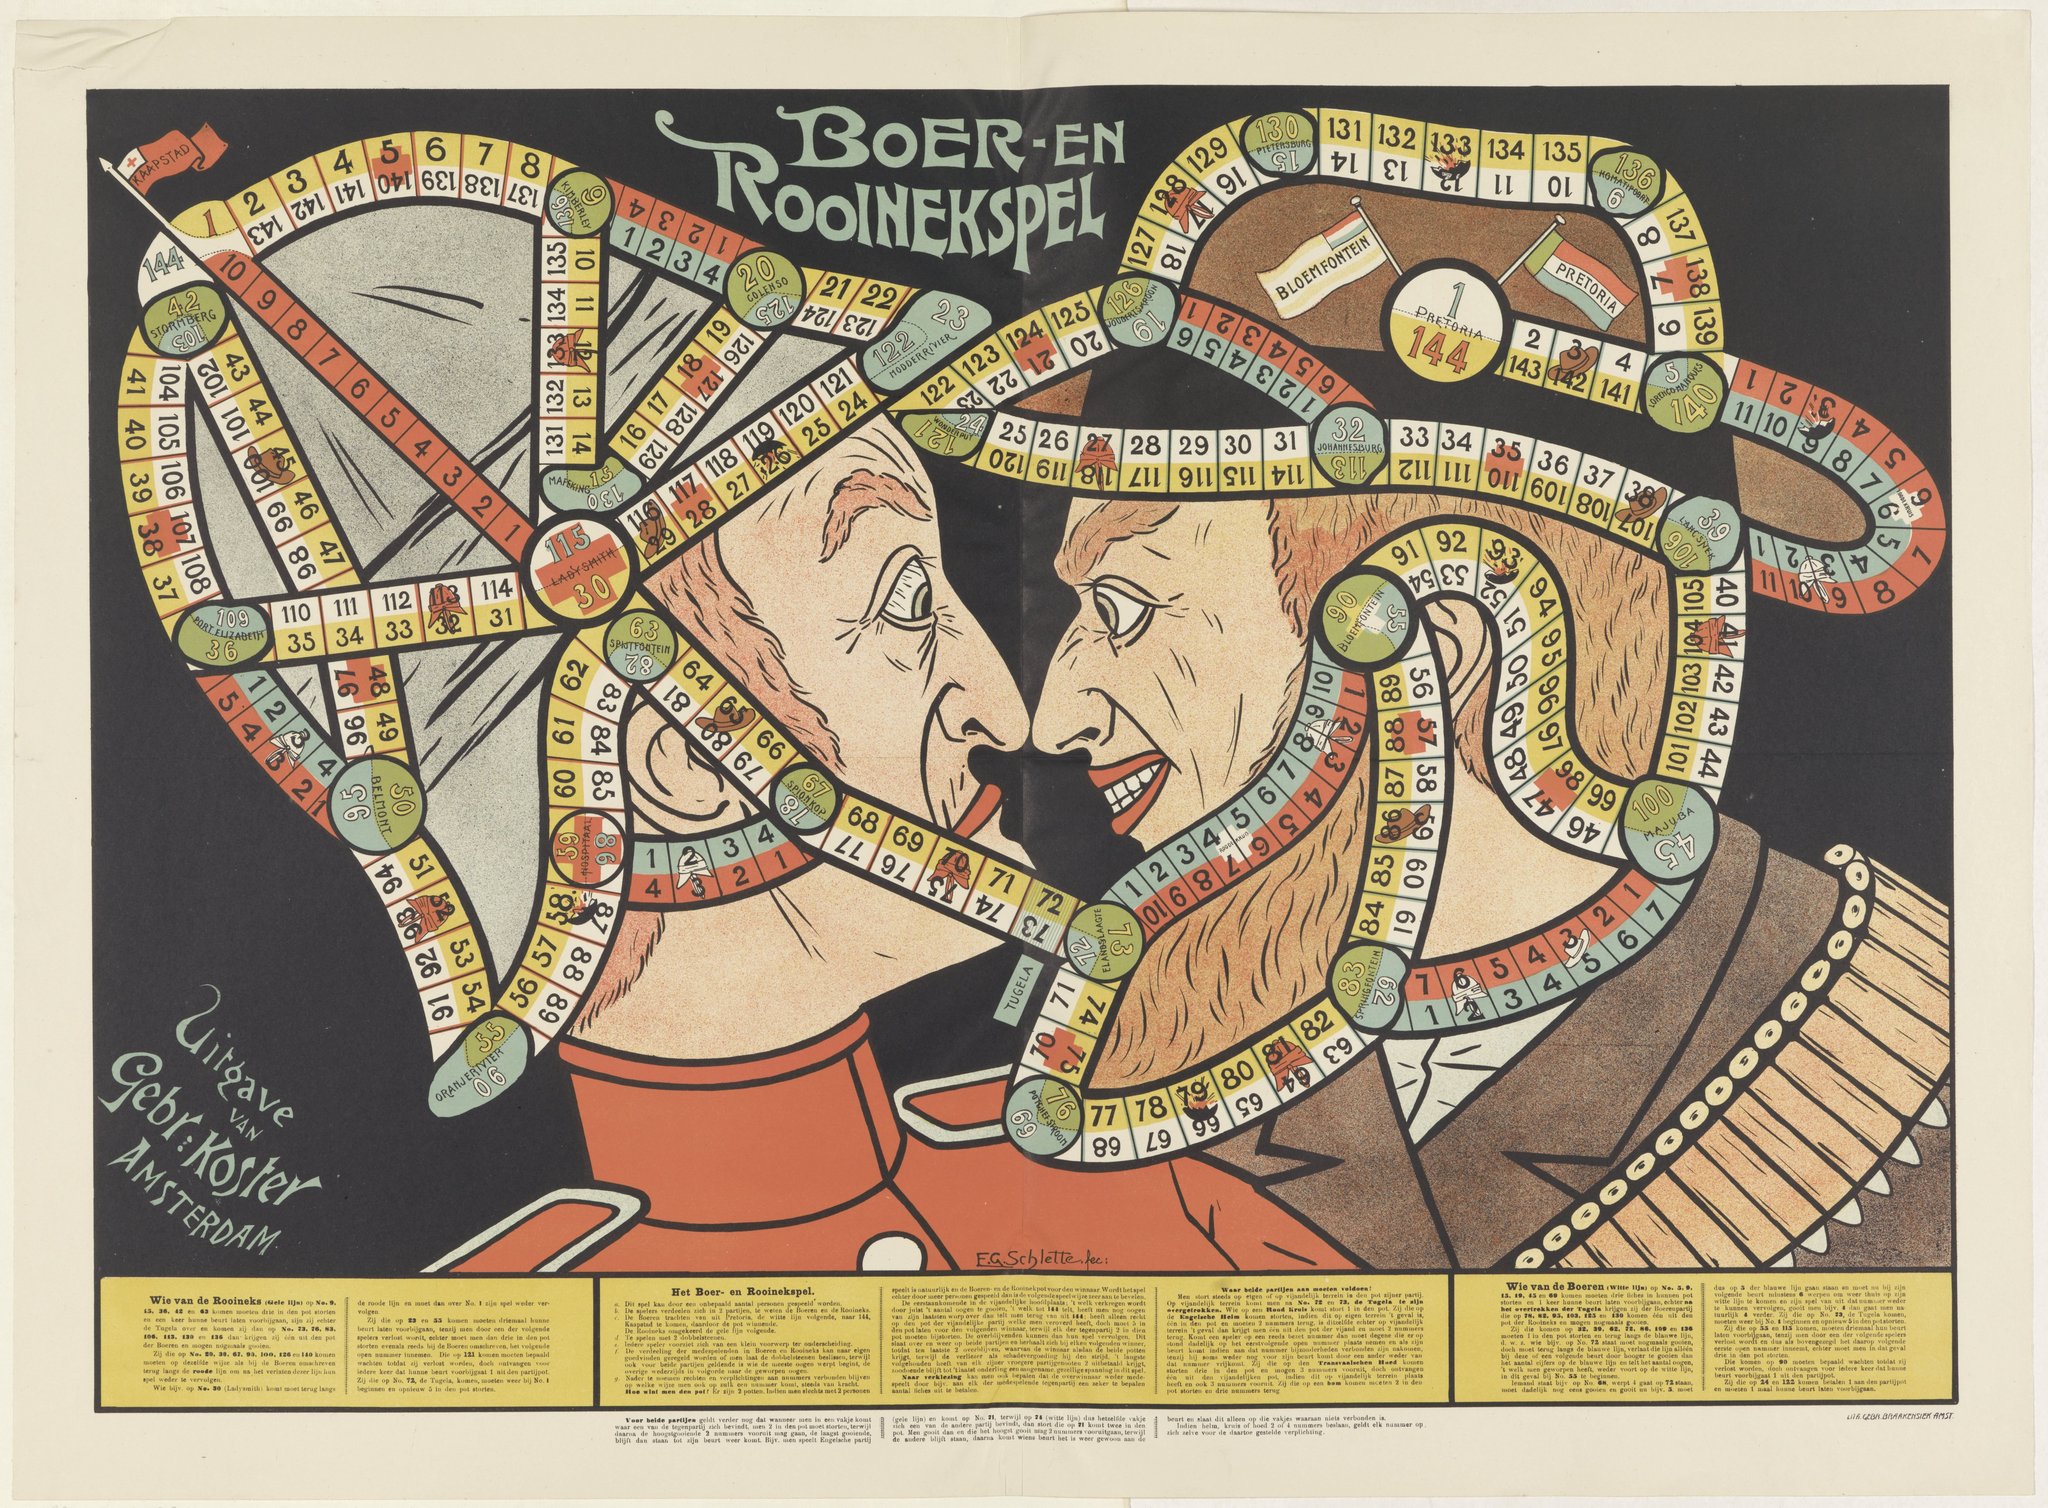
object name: print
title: Boer- en Rooinekspel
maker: f.g. schlette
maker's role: print maker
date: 1902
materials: paper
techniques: lithograph, letterpress printing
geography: amsterdam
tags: board-games of chance, farmers, the soldier; the soldier's life, board-games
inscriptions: collector's mark: Lugt 2760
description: Bordspel met als thema de Boerenoorlogen in Zuid-Afrika tussen de boeren en de Engelsen. Twee portretten met een lint van genummerde vakjes lopend over de contouren van hun hoofddeksels en over hun kinnen. Links een Engelse soldaat (Engelse soldaten werden geduid als "Rooinekken" omdat zij door de felle zon al snel een verbrande huid hadden in de nek), rechts een Zuid-Afrikaande boer met rode baard. In de ondermarge de spelregels in zeven kolommen.